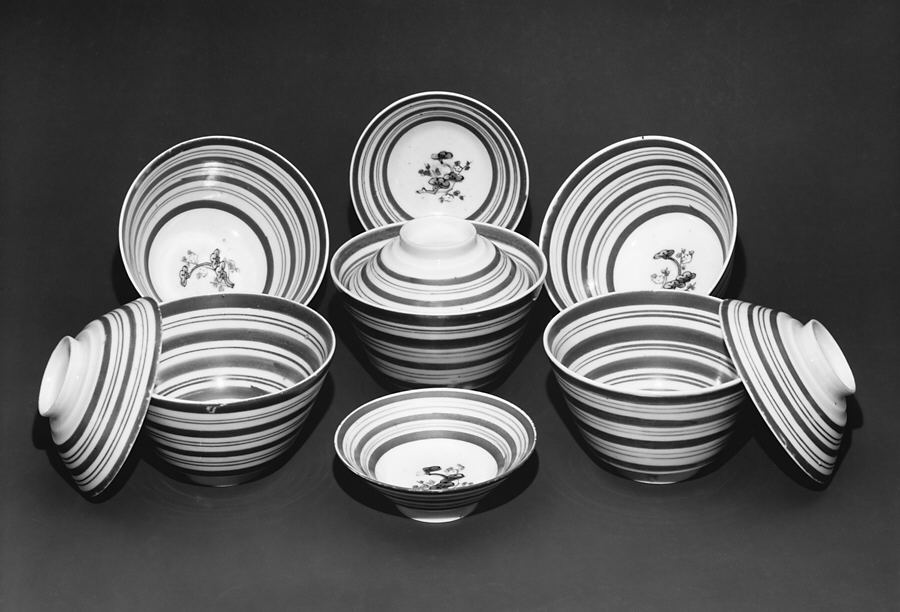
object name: covered bowl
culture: japanese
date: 1701-1800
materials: porcelain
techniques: underglaze